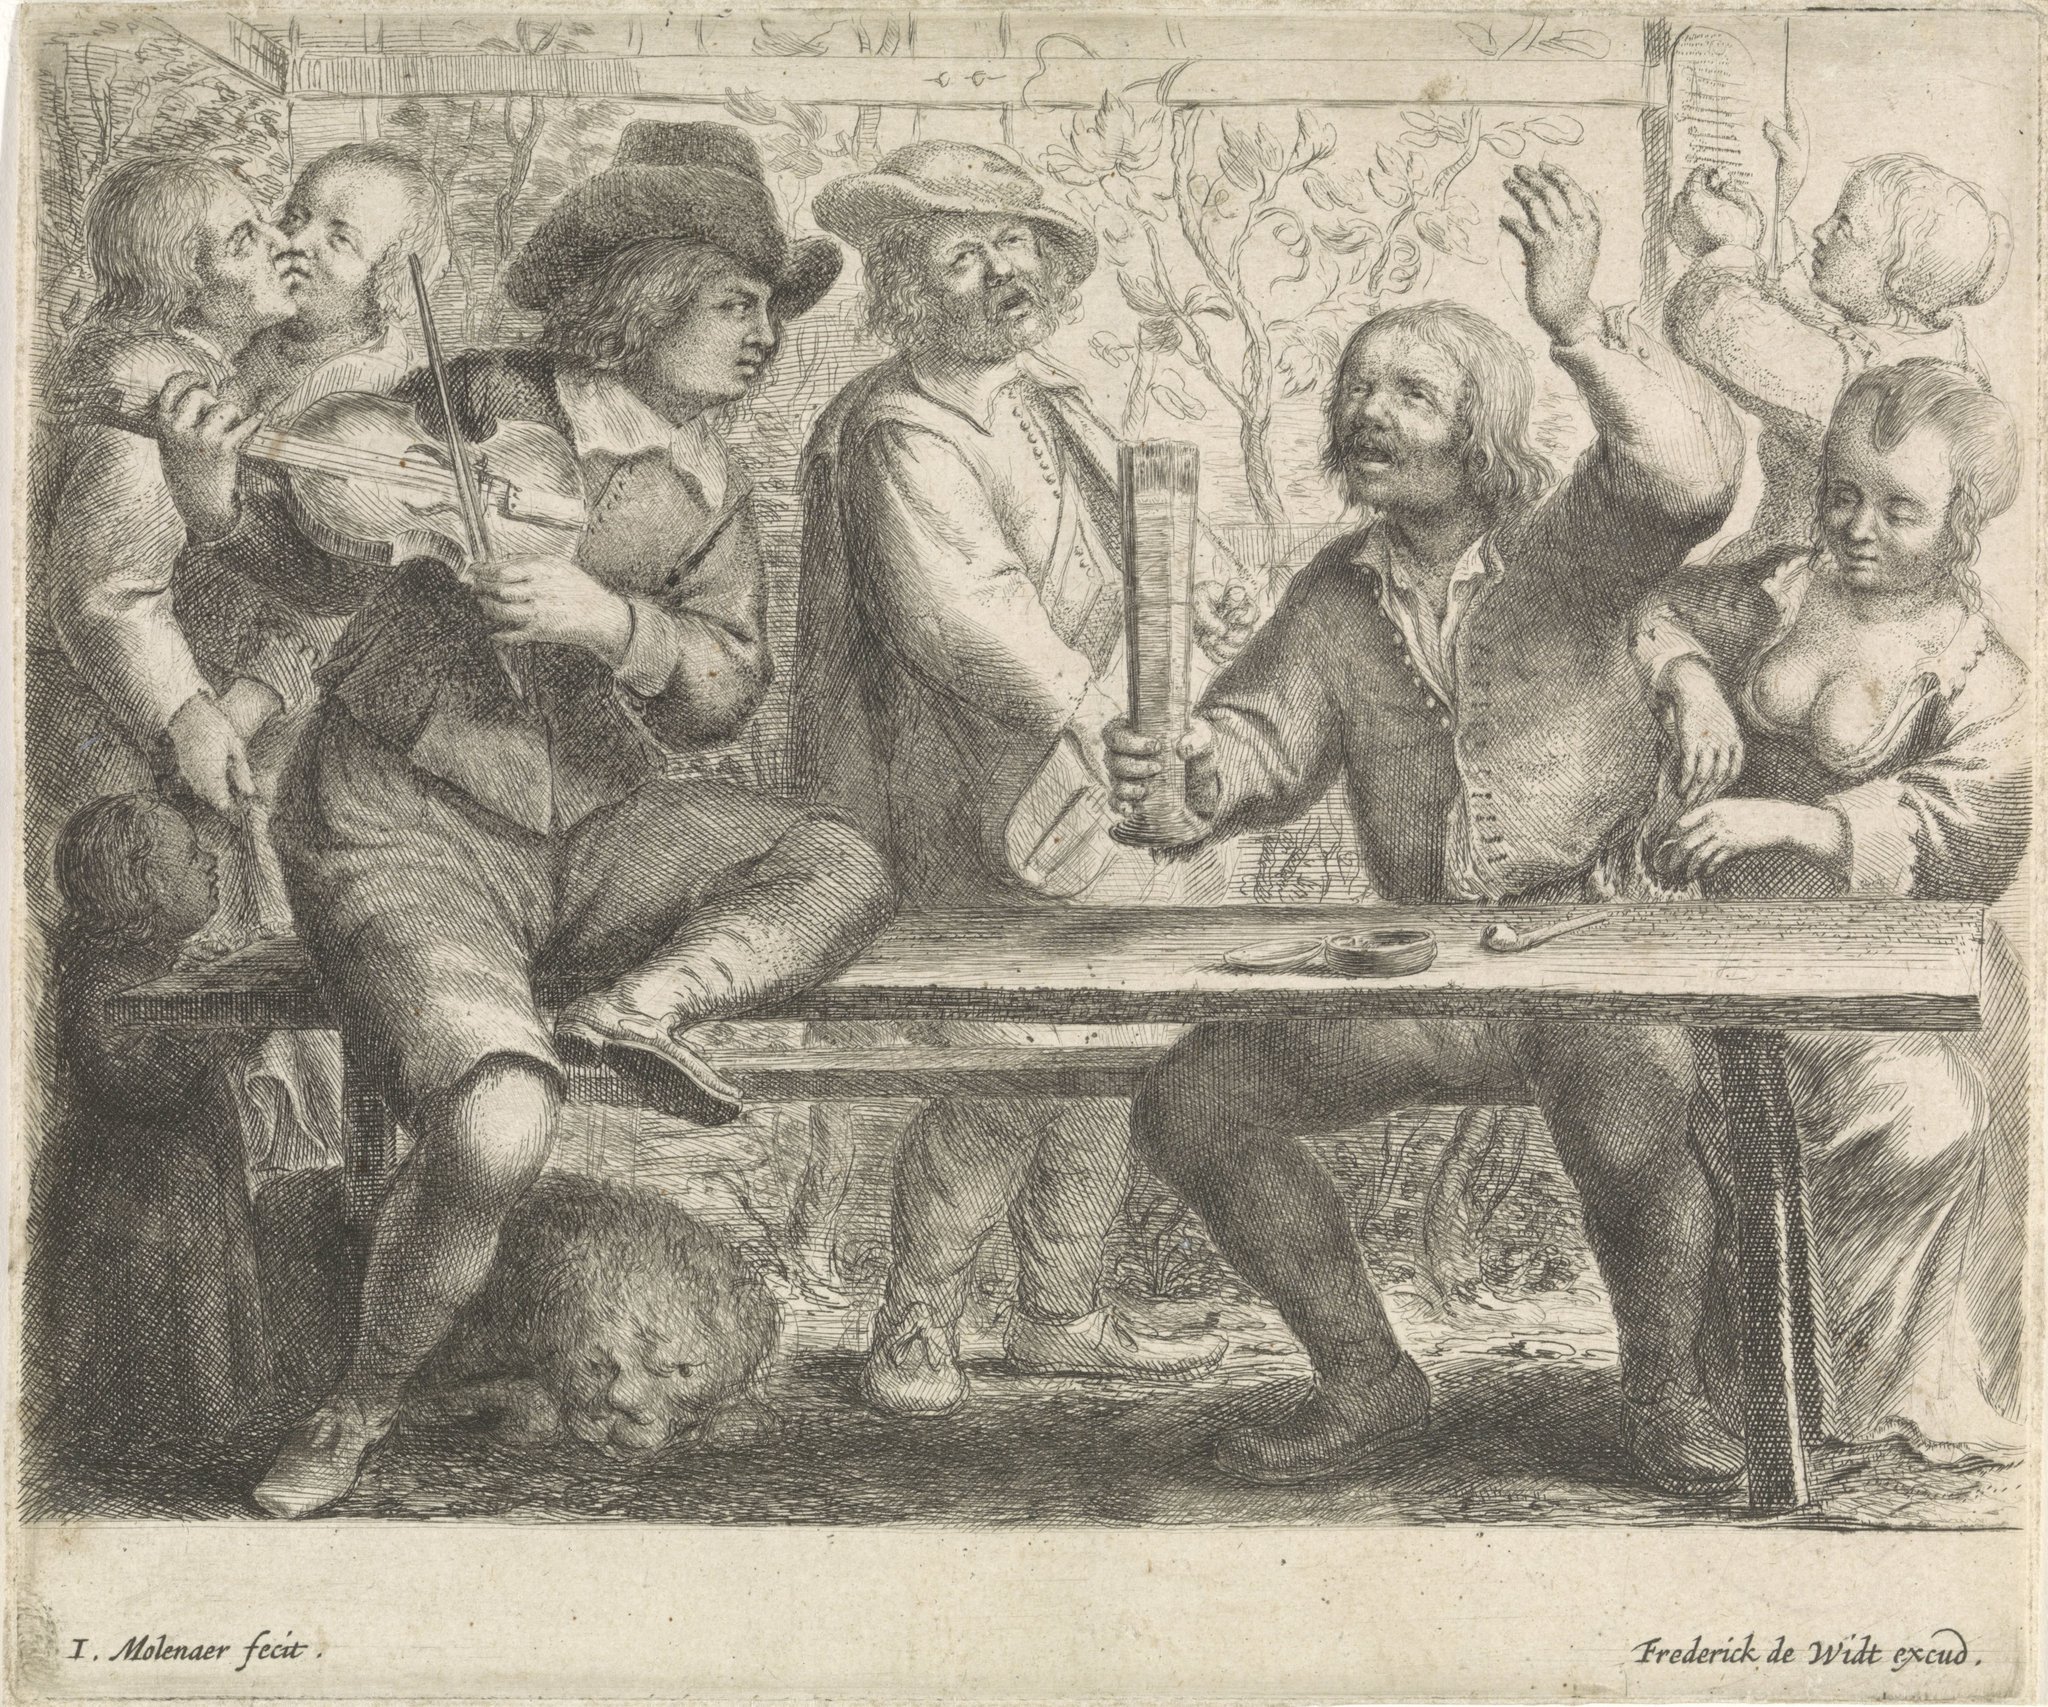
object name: print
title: Muzikanten en drinker in een herberg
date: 1619-1668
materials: paper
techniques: engraving, etching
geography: amsterdam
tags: (lovers) kissing each other, hurdy-gurdy player, glass, rummer, the man is robbed (brothel scene), dog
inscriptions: collector's mark: Lugt 240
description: In een herberg of bordeel zit een man achter een tafel met een glas in zijn hand. Hij wordt beroofd door een prostituee. Bij de tafel twee muzikanten, waarvan de een met een viool en de ander zingend met een draailier in de handen. Links een minnekozend paar en een kind. Rechtsachter houdt een vrouw de genuttigde consumpties bij. Onder de tafel een hond.